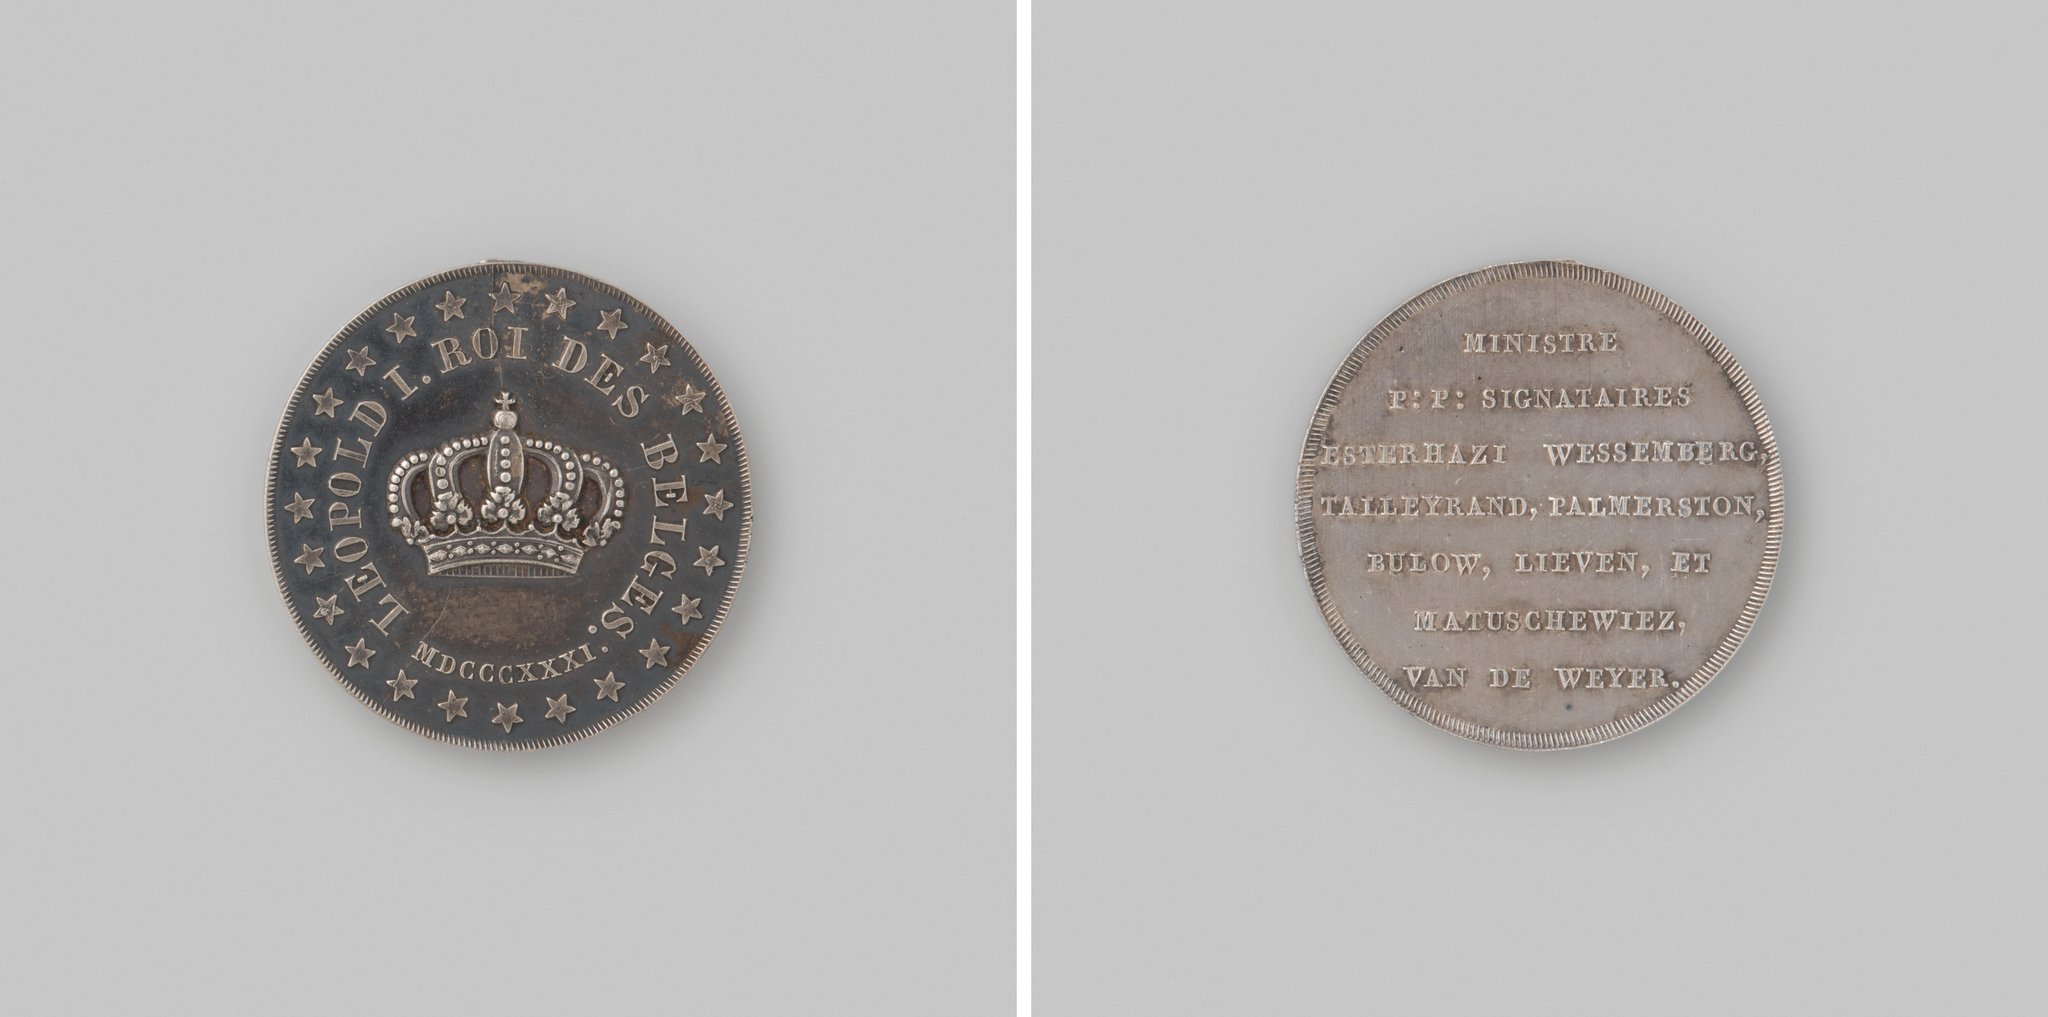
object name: strooipenning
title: Erkenning van de onafhankelijkeid van het koninkrijk België door de XXIV Artikelen van de conferentie van Londen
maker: laurent joseph hart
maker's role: die cutter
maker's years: 1810-1860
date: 1831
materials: silver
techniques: striking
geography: brussels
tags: paris, politician, charles maurice hertog van talleyrand-périgord, laeken, leopold i (koning der belgen), london, belgium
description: Zilveren penning. Voorzijde: kroon binnen omschrift en sterrekrans. Keerzijde: opschrift